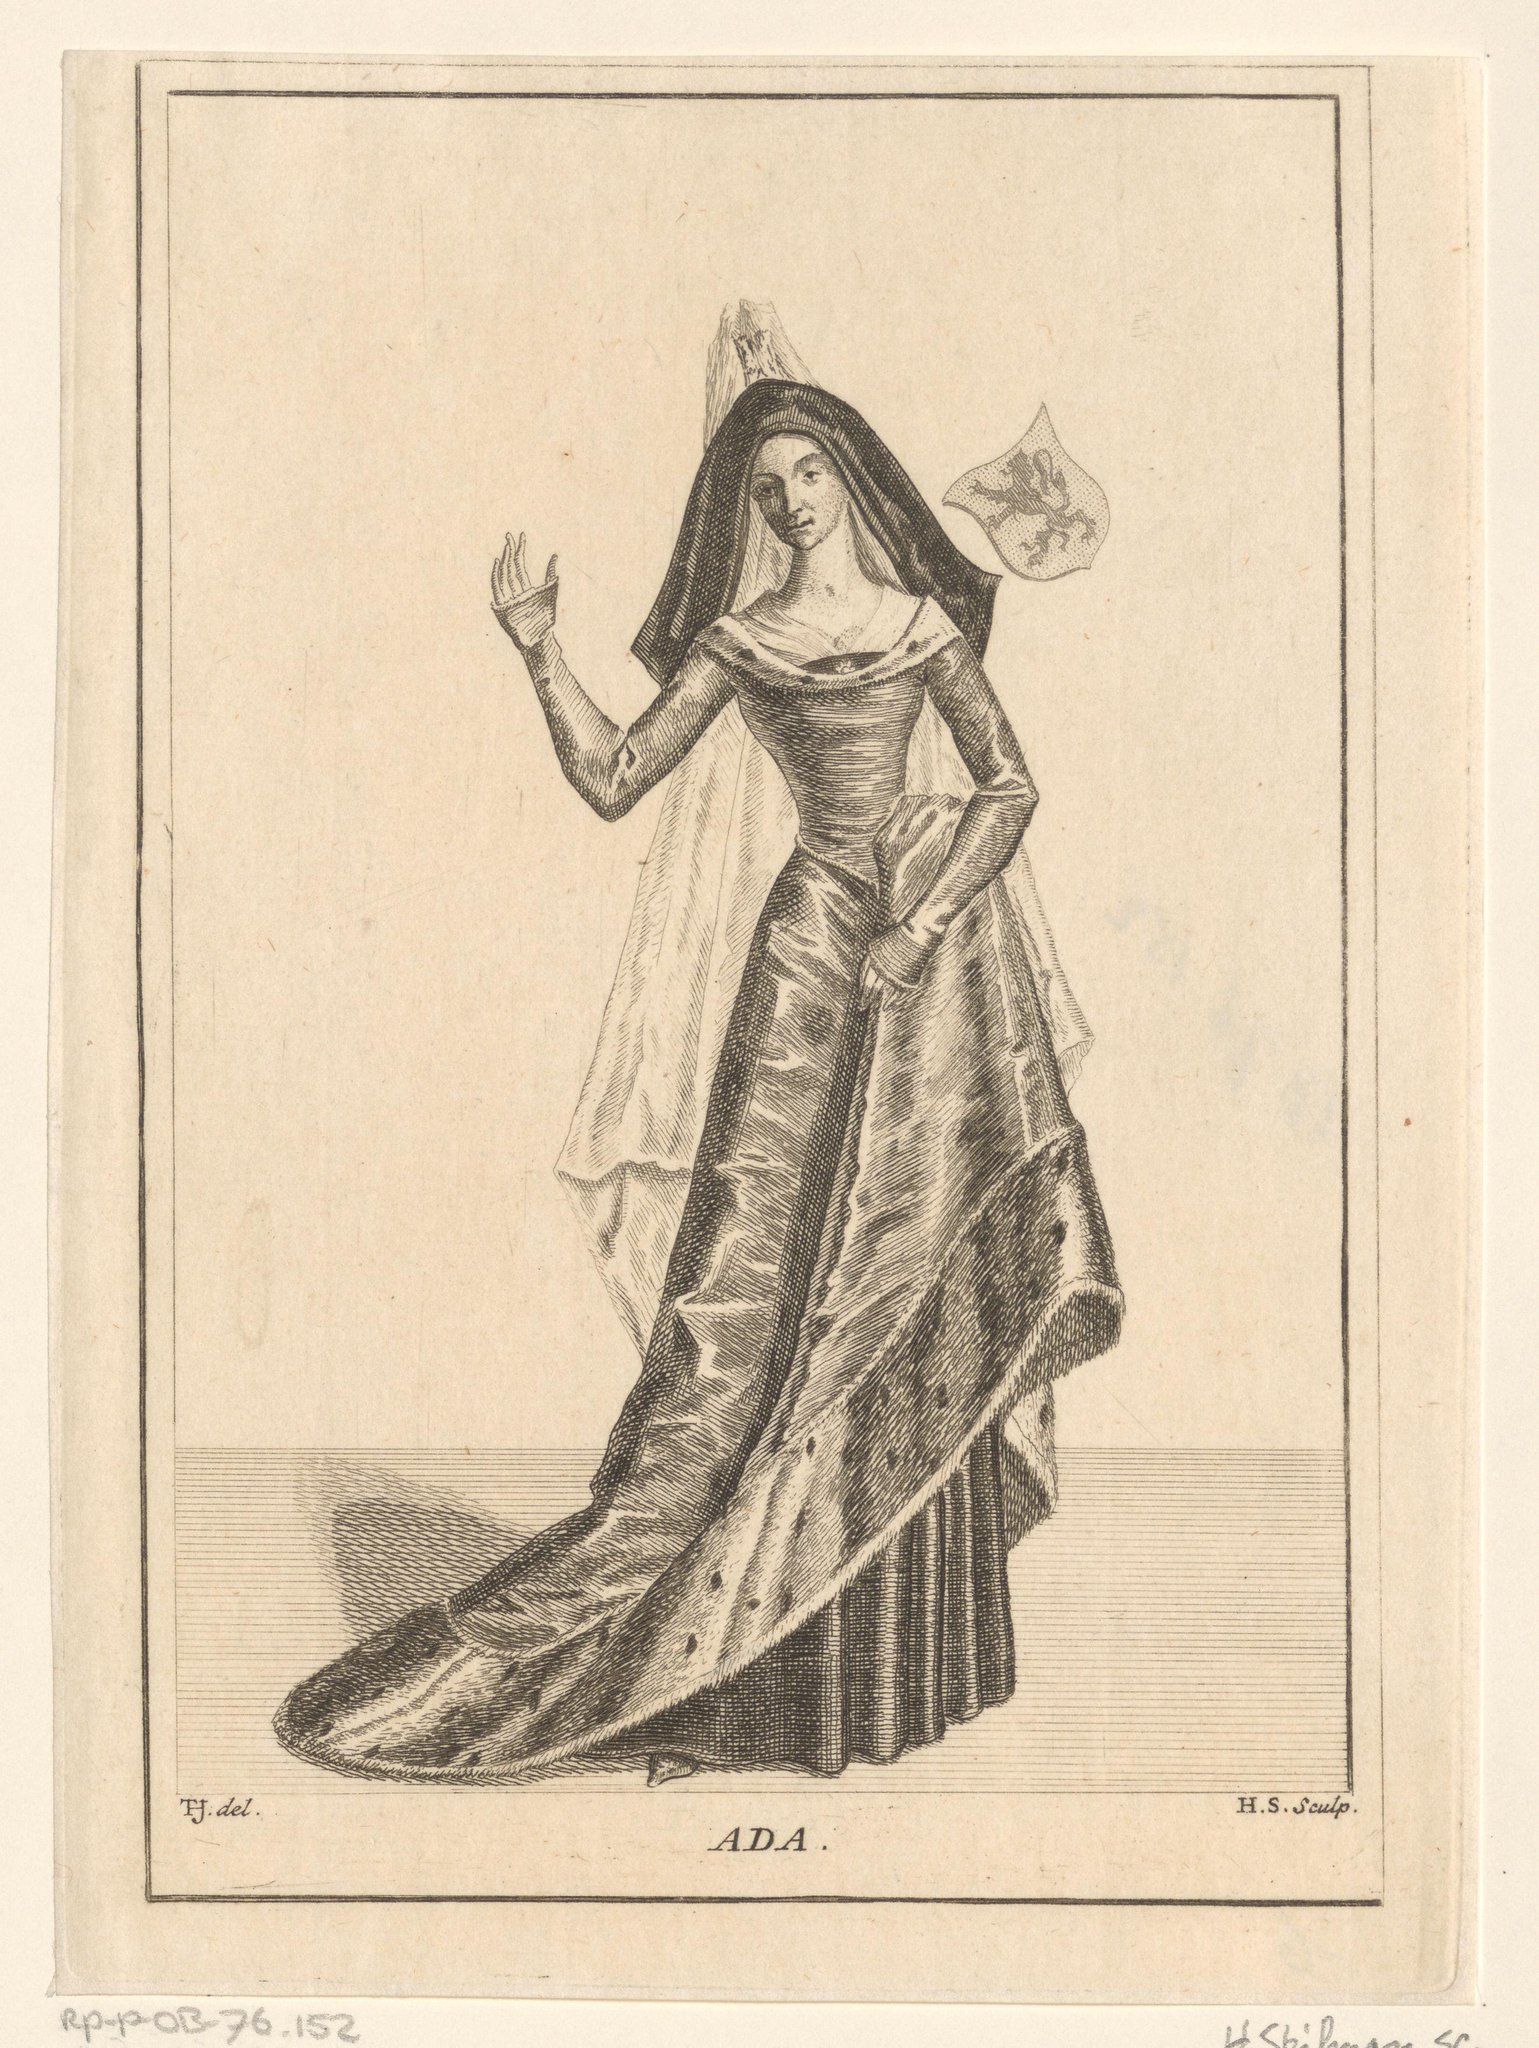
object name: print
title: Portret van Ada, gravin van Holland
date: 1742-1784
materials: paper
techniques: etching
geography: haarlem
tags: gravin, ada (gravin van holland)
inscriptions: collector's mark: Lugt 2228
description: Portret van Ada in een rechthoekige omlijsting. Rechtsboven haar wapen. In de ondermarge haar naam.